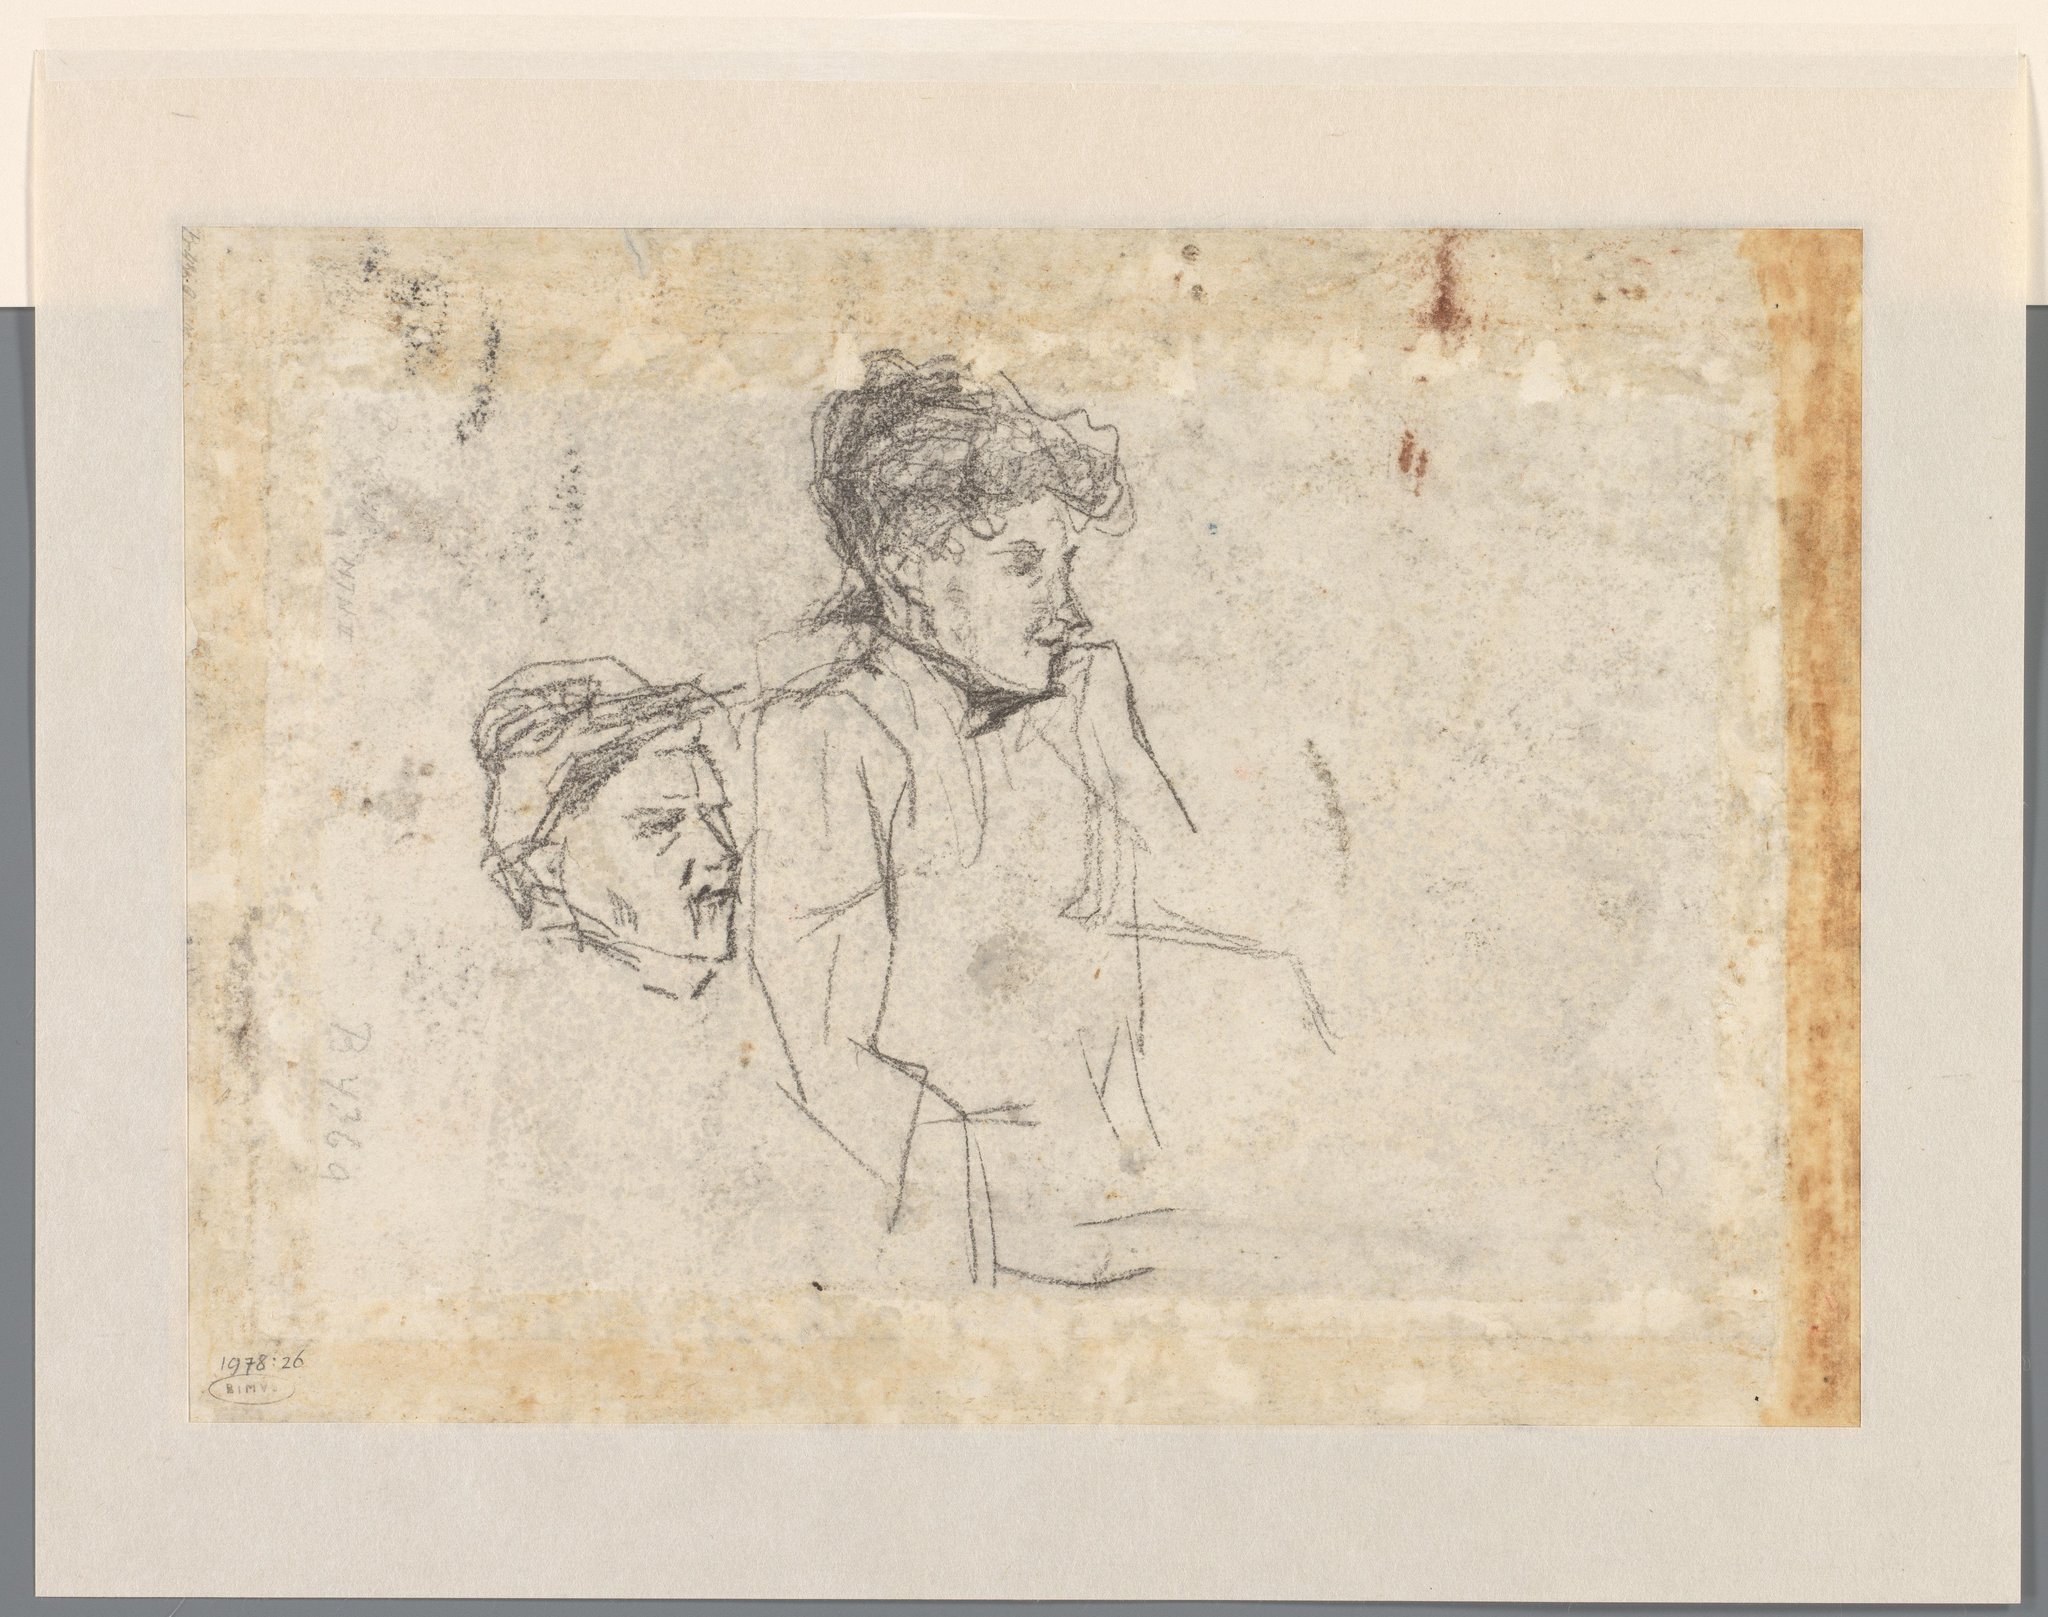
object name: drawing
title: Schets van een vrouw ten halven lijve en van een vrouwenkop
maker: gerrit willem dijsselhof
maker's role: designer, draughtsman, print maker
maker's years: 1866-1924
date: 1876-1924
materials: chalk, paper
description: Schets van een vrouw ten halven lijve en van een vrouwenkop.